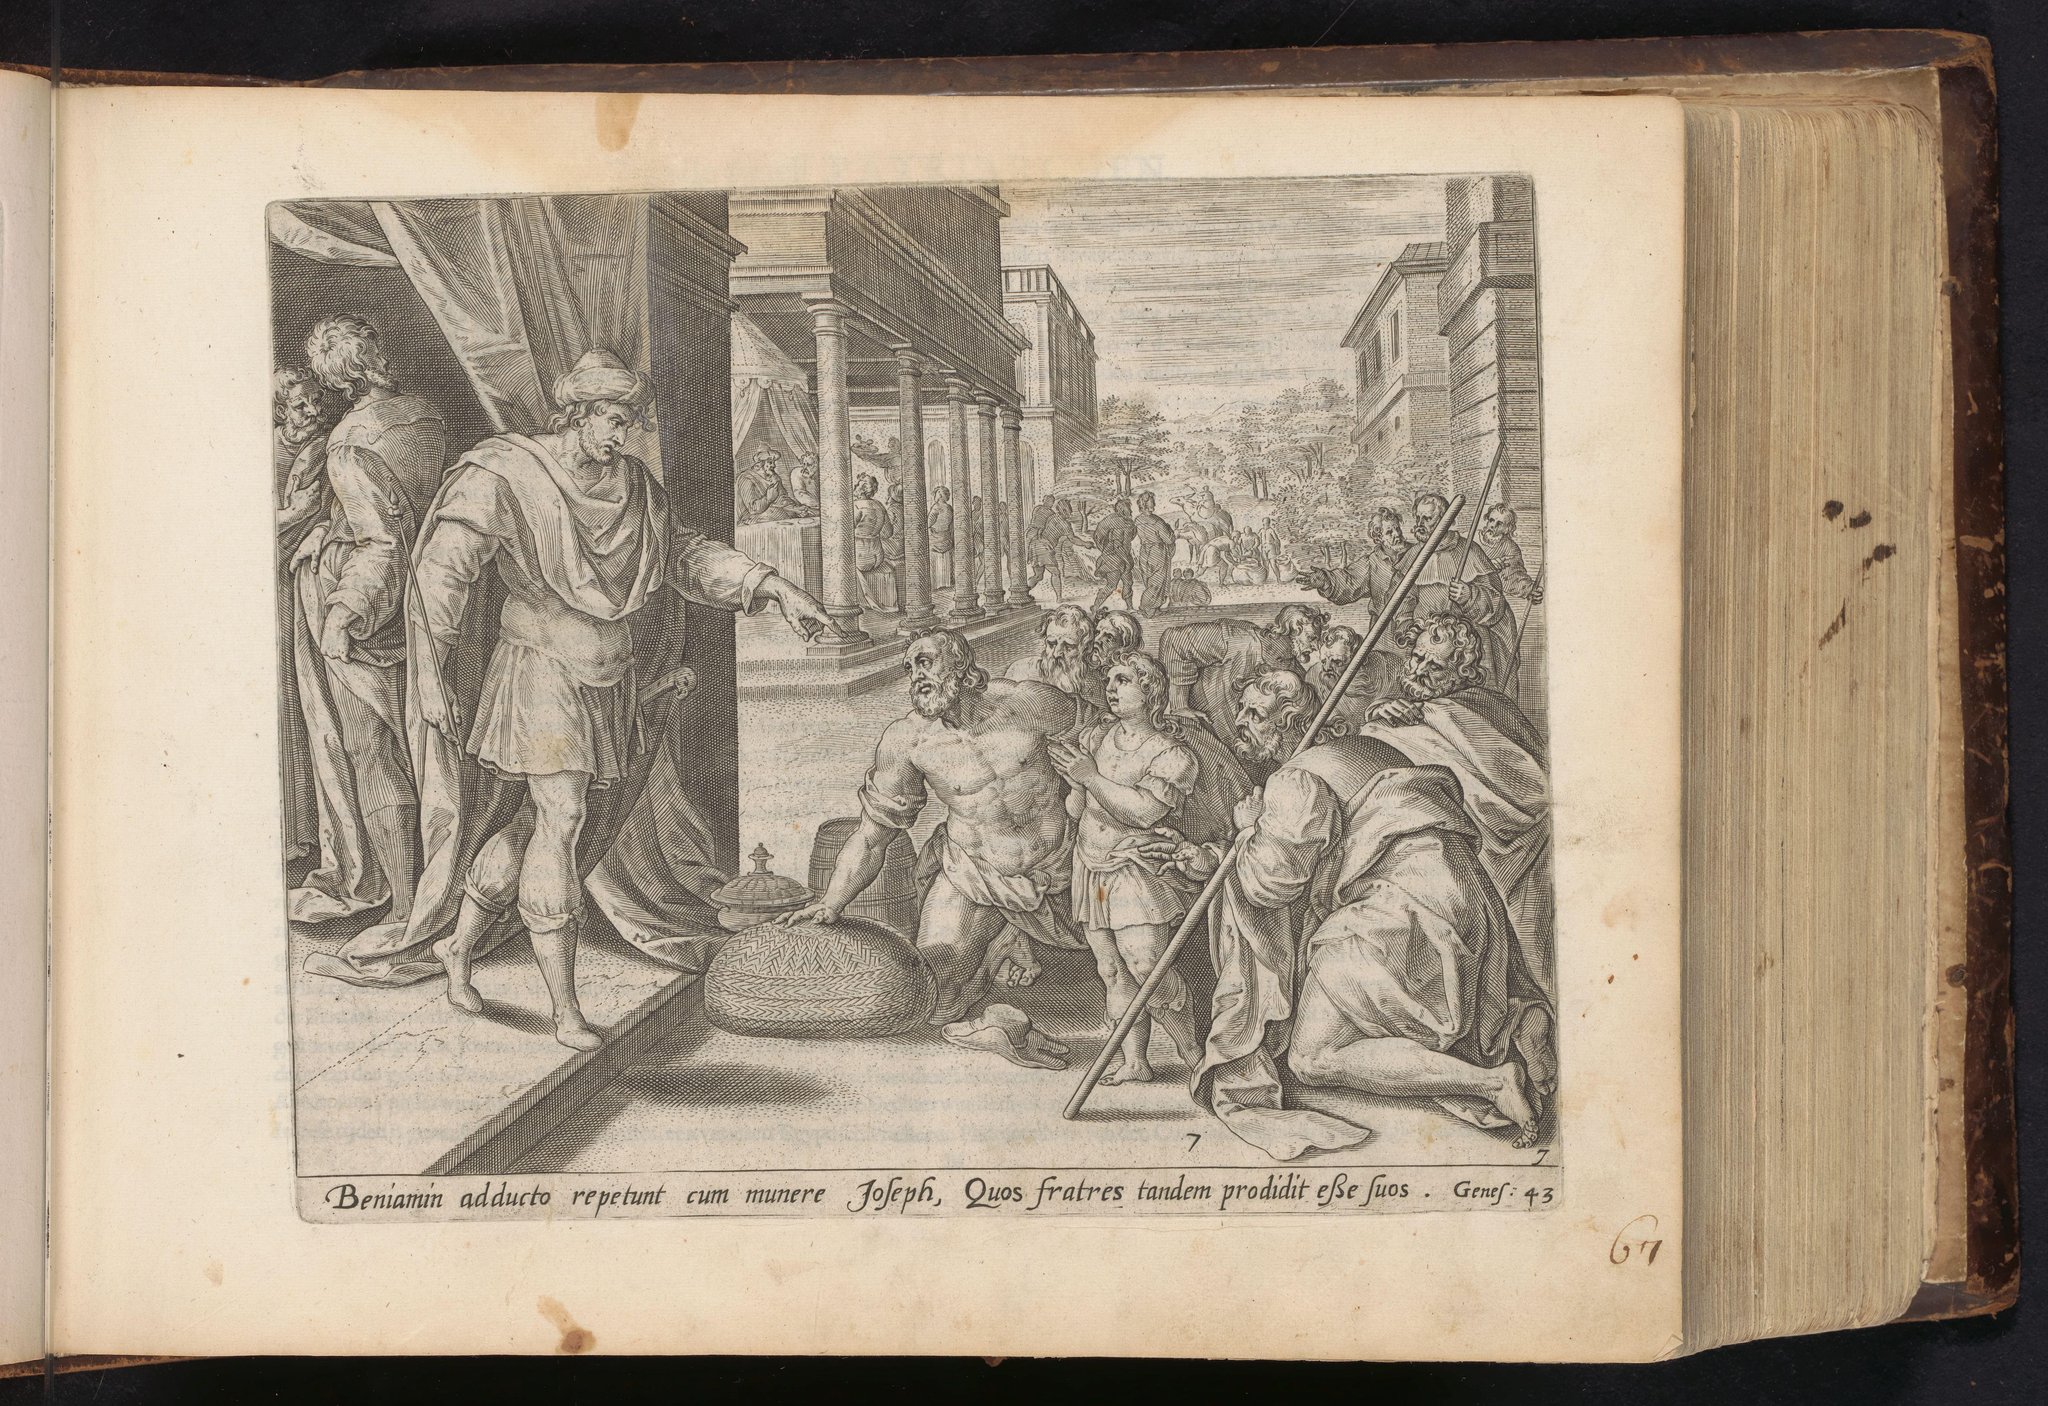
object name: album leaf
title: Den Grooten Figuer-Bibel (...)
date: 1579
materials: paper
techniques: engraving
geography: amsterdam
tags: joseph receives his brothers and benjamin, the missing cup ~ story of joseph (genesis 44-45), the feast at joseph's house: the amazement of his brothers at being seated according to their age; benjamin is honoured with extra food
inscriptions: number: ‘67’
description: Jozefs broers zijn met hun kleine broer Benjamin teruggekeerd naar Egypte en knielen voor Jozef. Hij nodigt hen uit voor een maaltijd. Linksachter zitten de broers tegenover Jozef aan de maaltijd. Geheel op de achtergrond is het vervolg van het verhaal te zien: in de zak graan van Benjamin wordt de zilveren beker van Jozef gevonden. Onder de voorstelling een verwijzing in het Latijn naar de Bijbeltekst in Gen. 43. Deze prent maakt deel uit van een album.